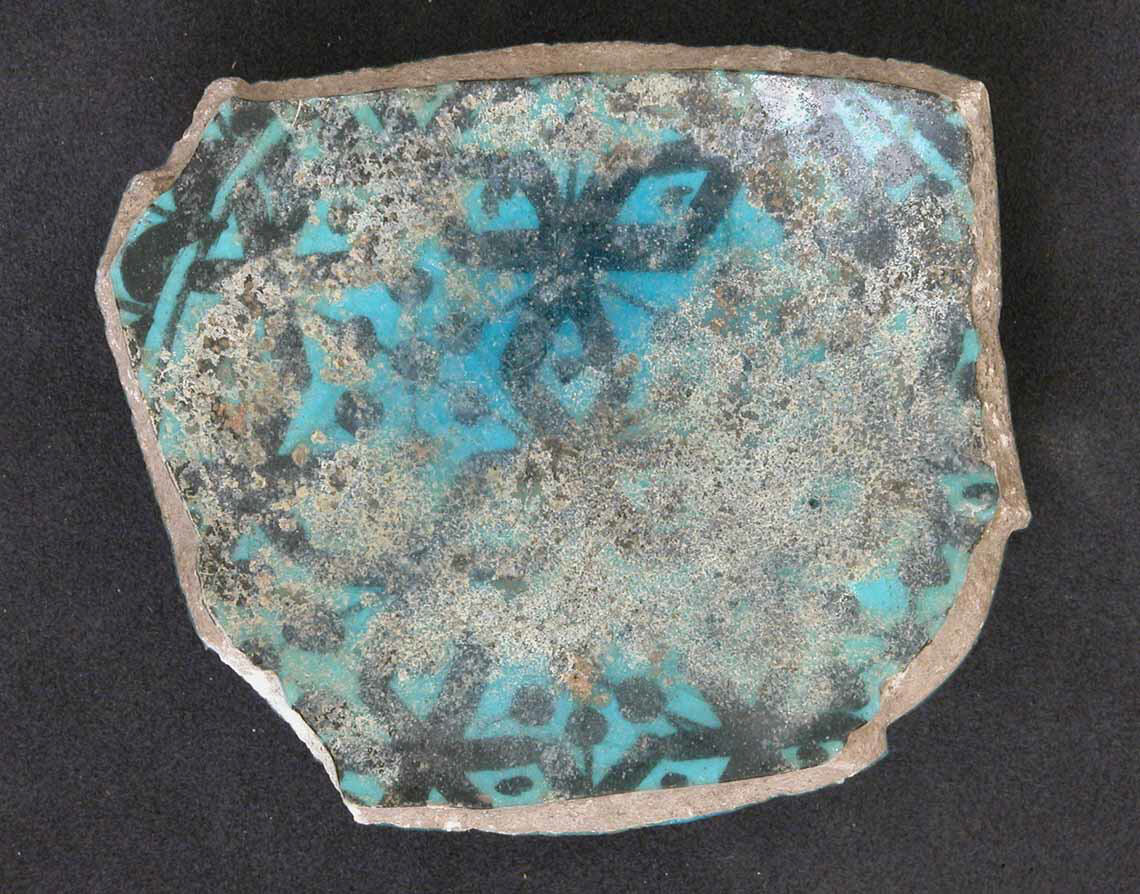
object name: fragment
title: Fragment of a Bowl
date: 1201-1400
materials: stonepaste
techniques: painting, underglaze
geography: syria